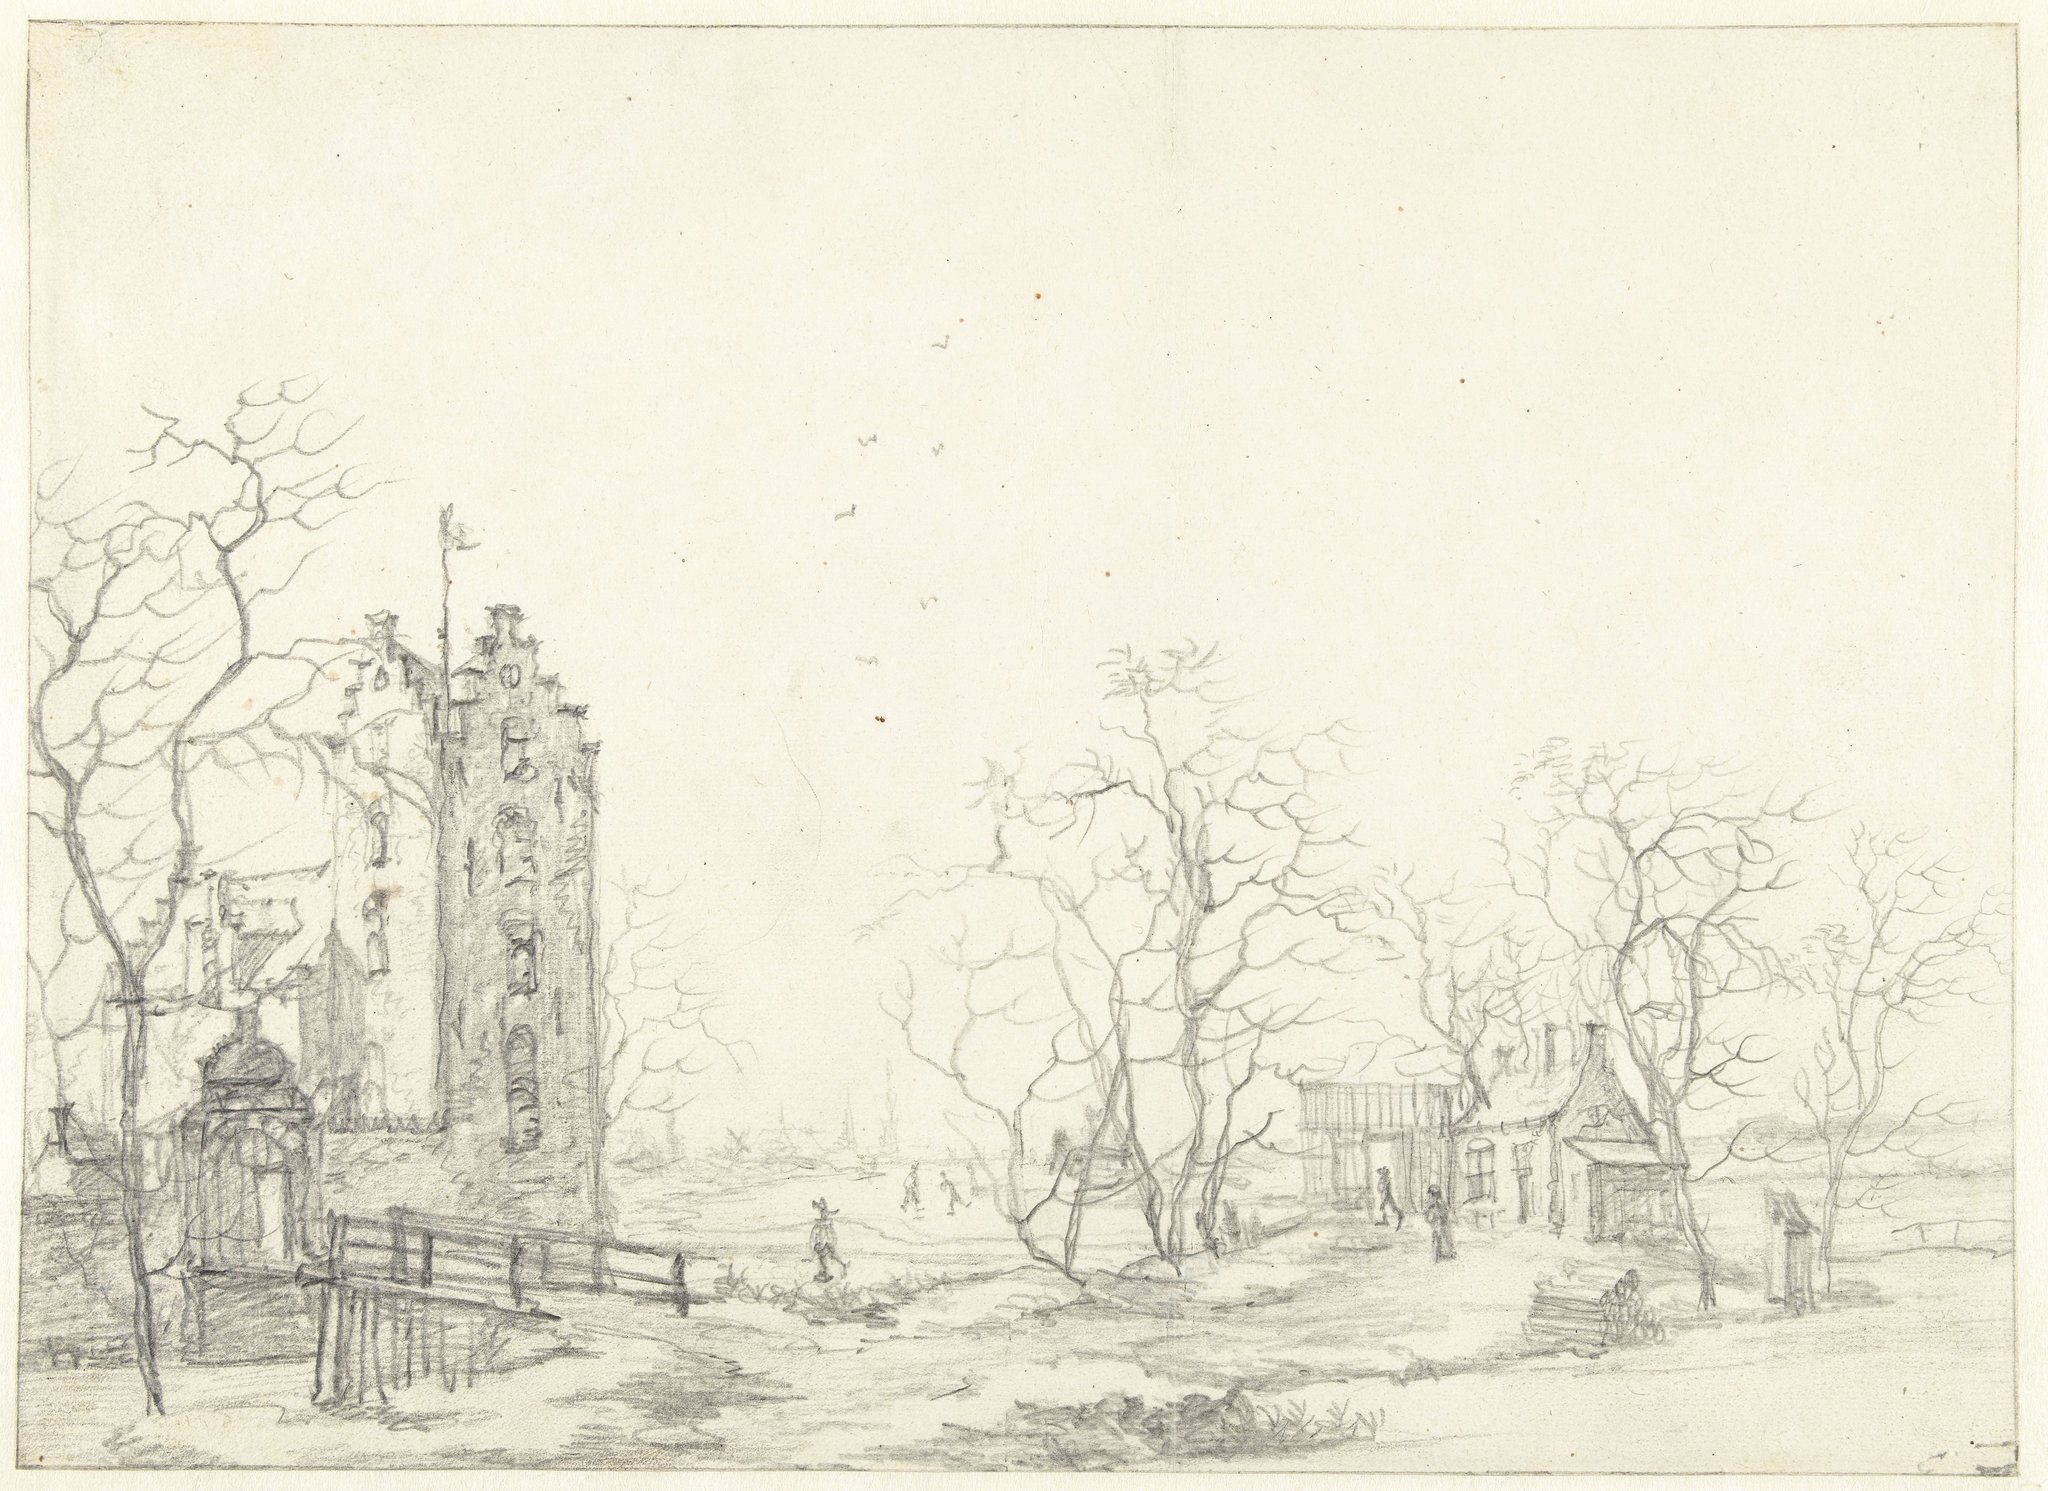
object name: drawing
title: Huis Kostverloren bij Amsterdam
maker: anthonie beerstraten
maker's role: draughtsman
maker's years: -1665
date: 1600-1699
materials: chalk, graphite, paper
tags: outskirts of city (+ city (-scape) with figures, staffage), skates (winter sports), country-house, amsterdam